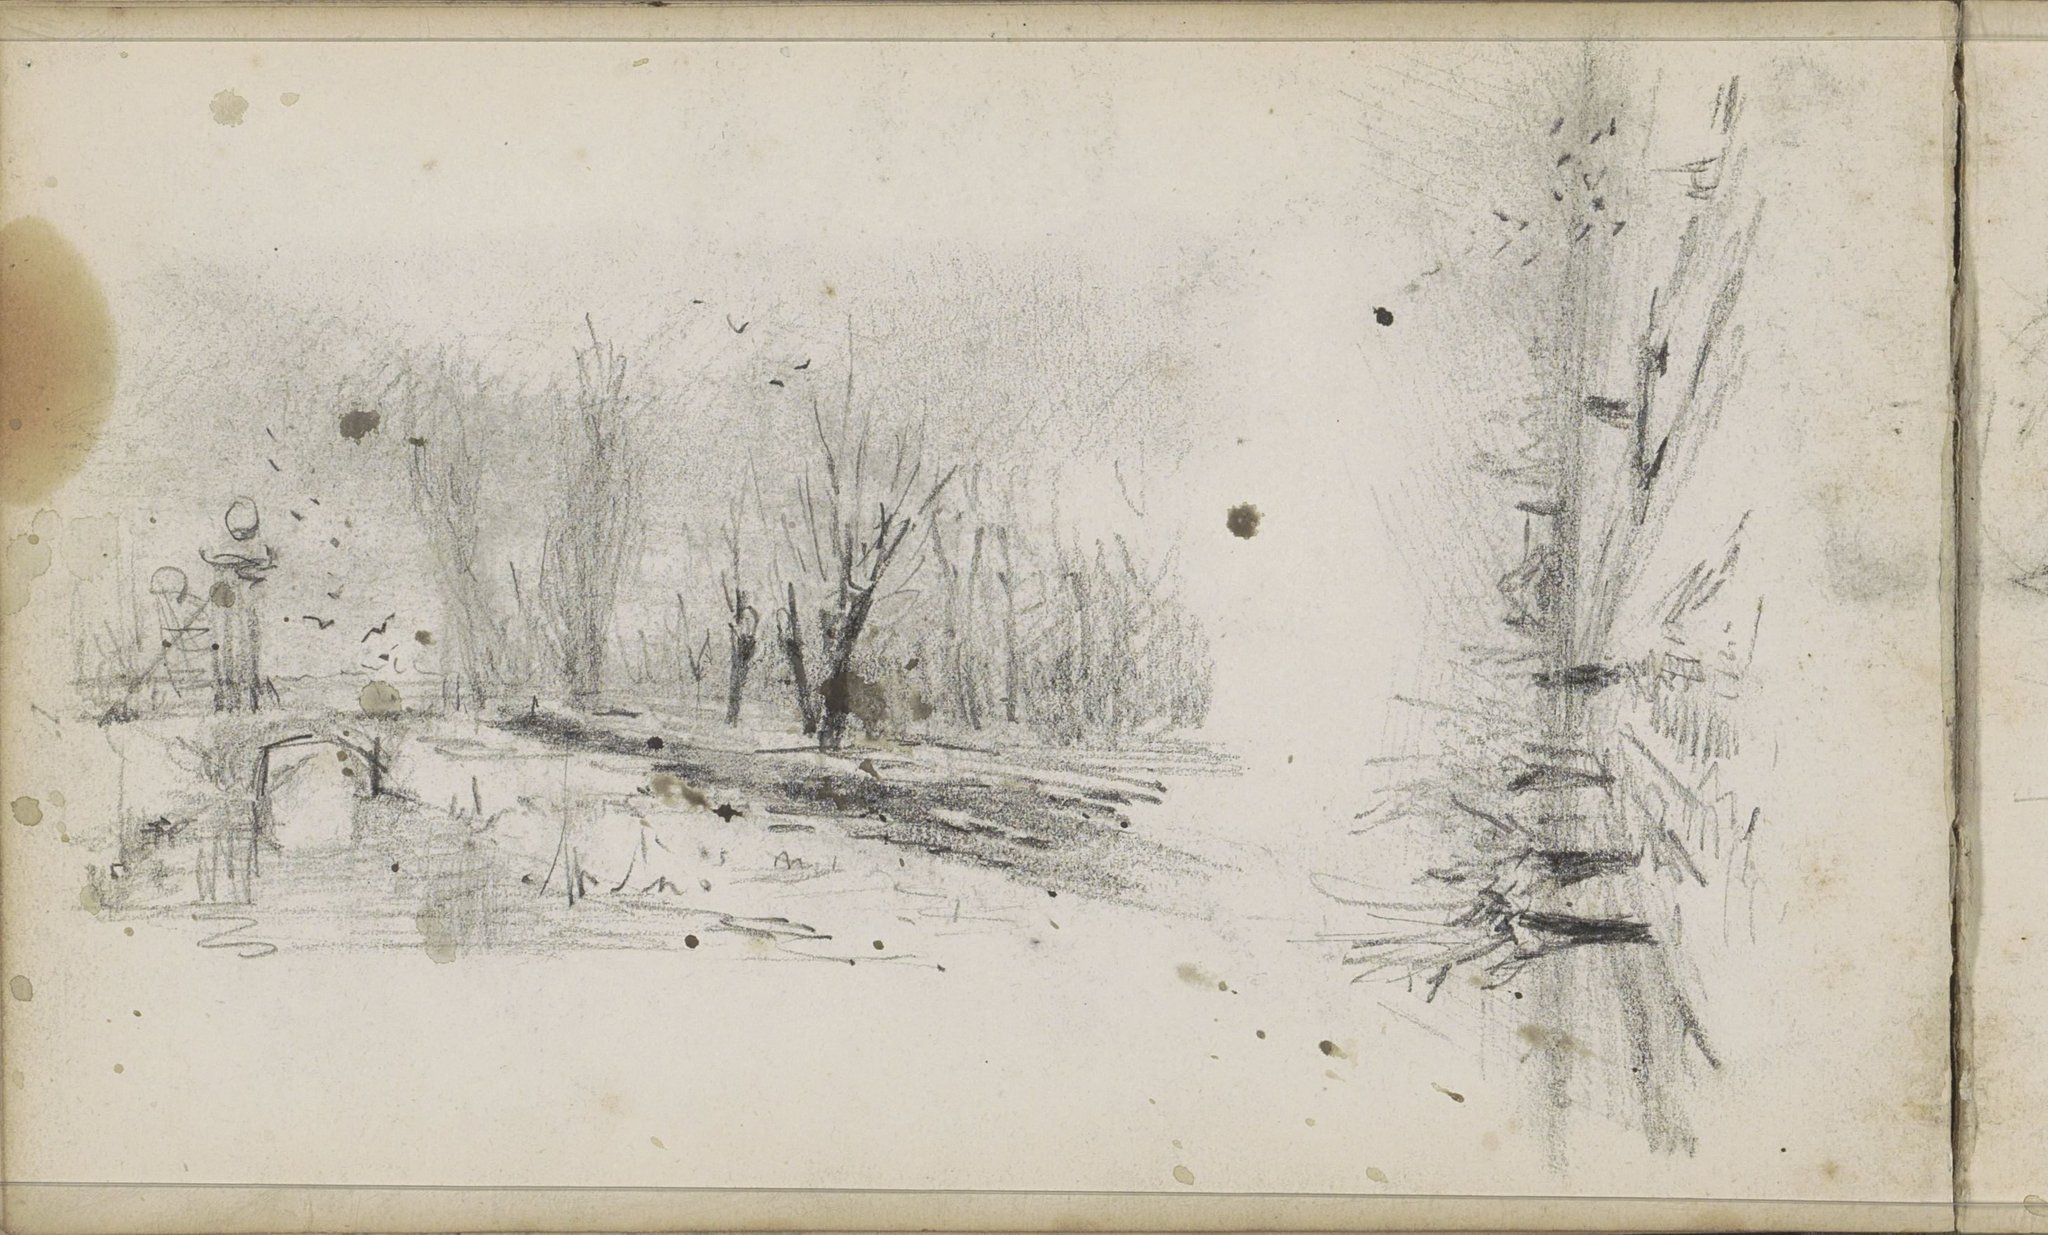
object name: sketchbook leaf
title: Knotwilgen langs een vaart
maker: willem cornelis rip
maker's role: draughtsman, painter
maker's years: 1856-1922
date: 1876-1877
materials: paper, pencil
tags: canal, trees: willow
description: Blad 15 verso uit een schetsboek met 41 bladen.